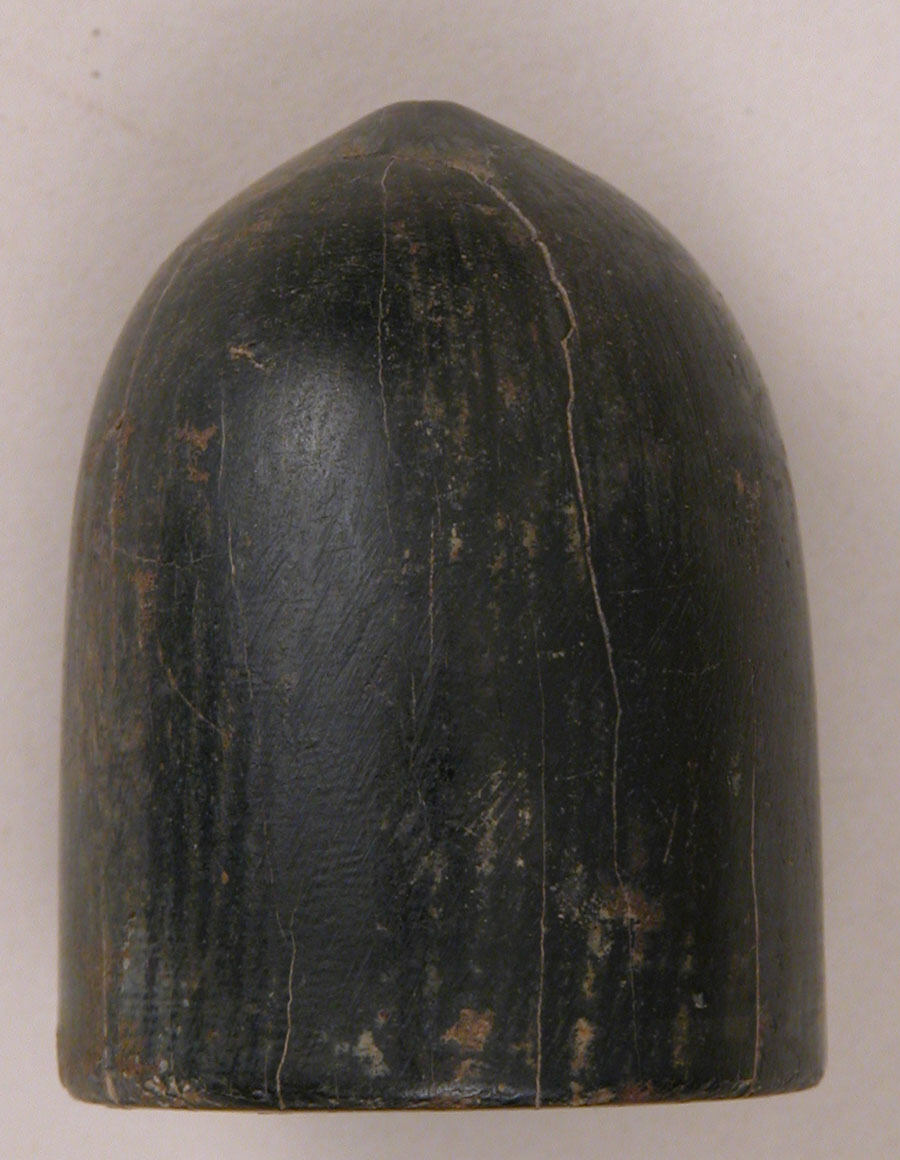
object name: chess or backgammon piece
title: Chess Piece, Pawn or Backgammon Piece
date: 801-1100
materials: ivory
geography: western islamic lands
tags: chess